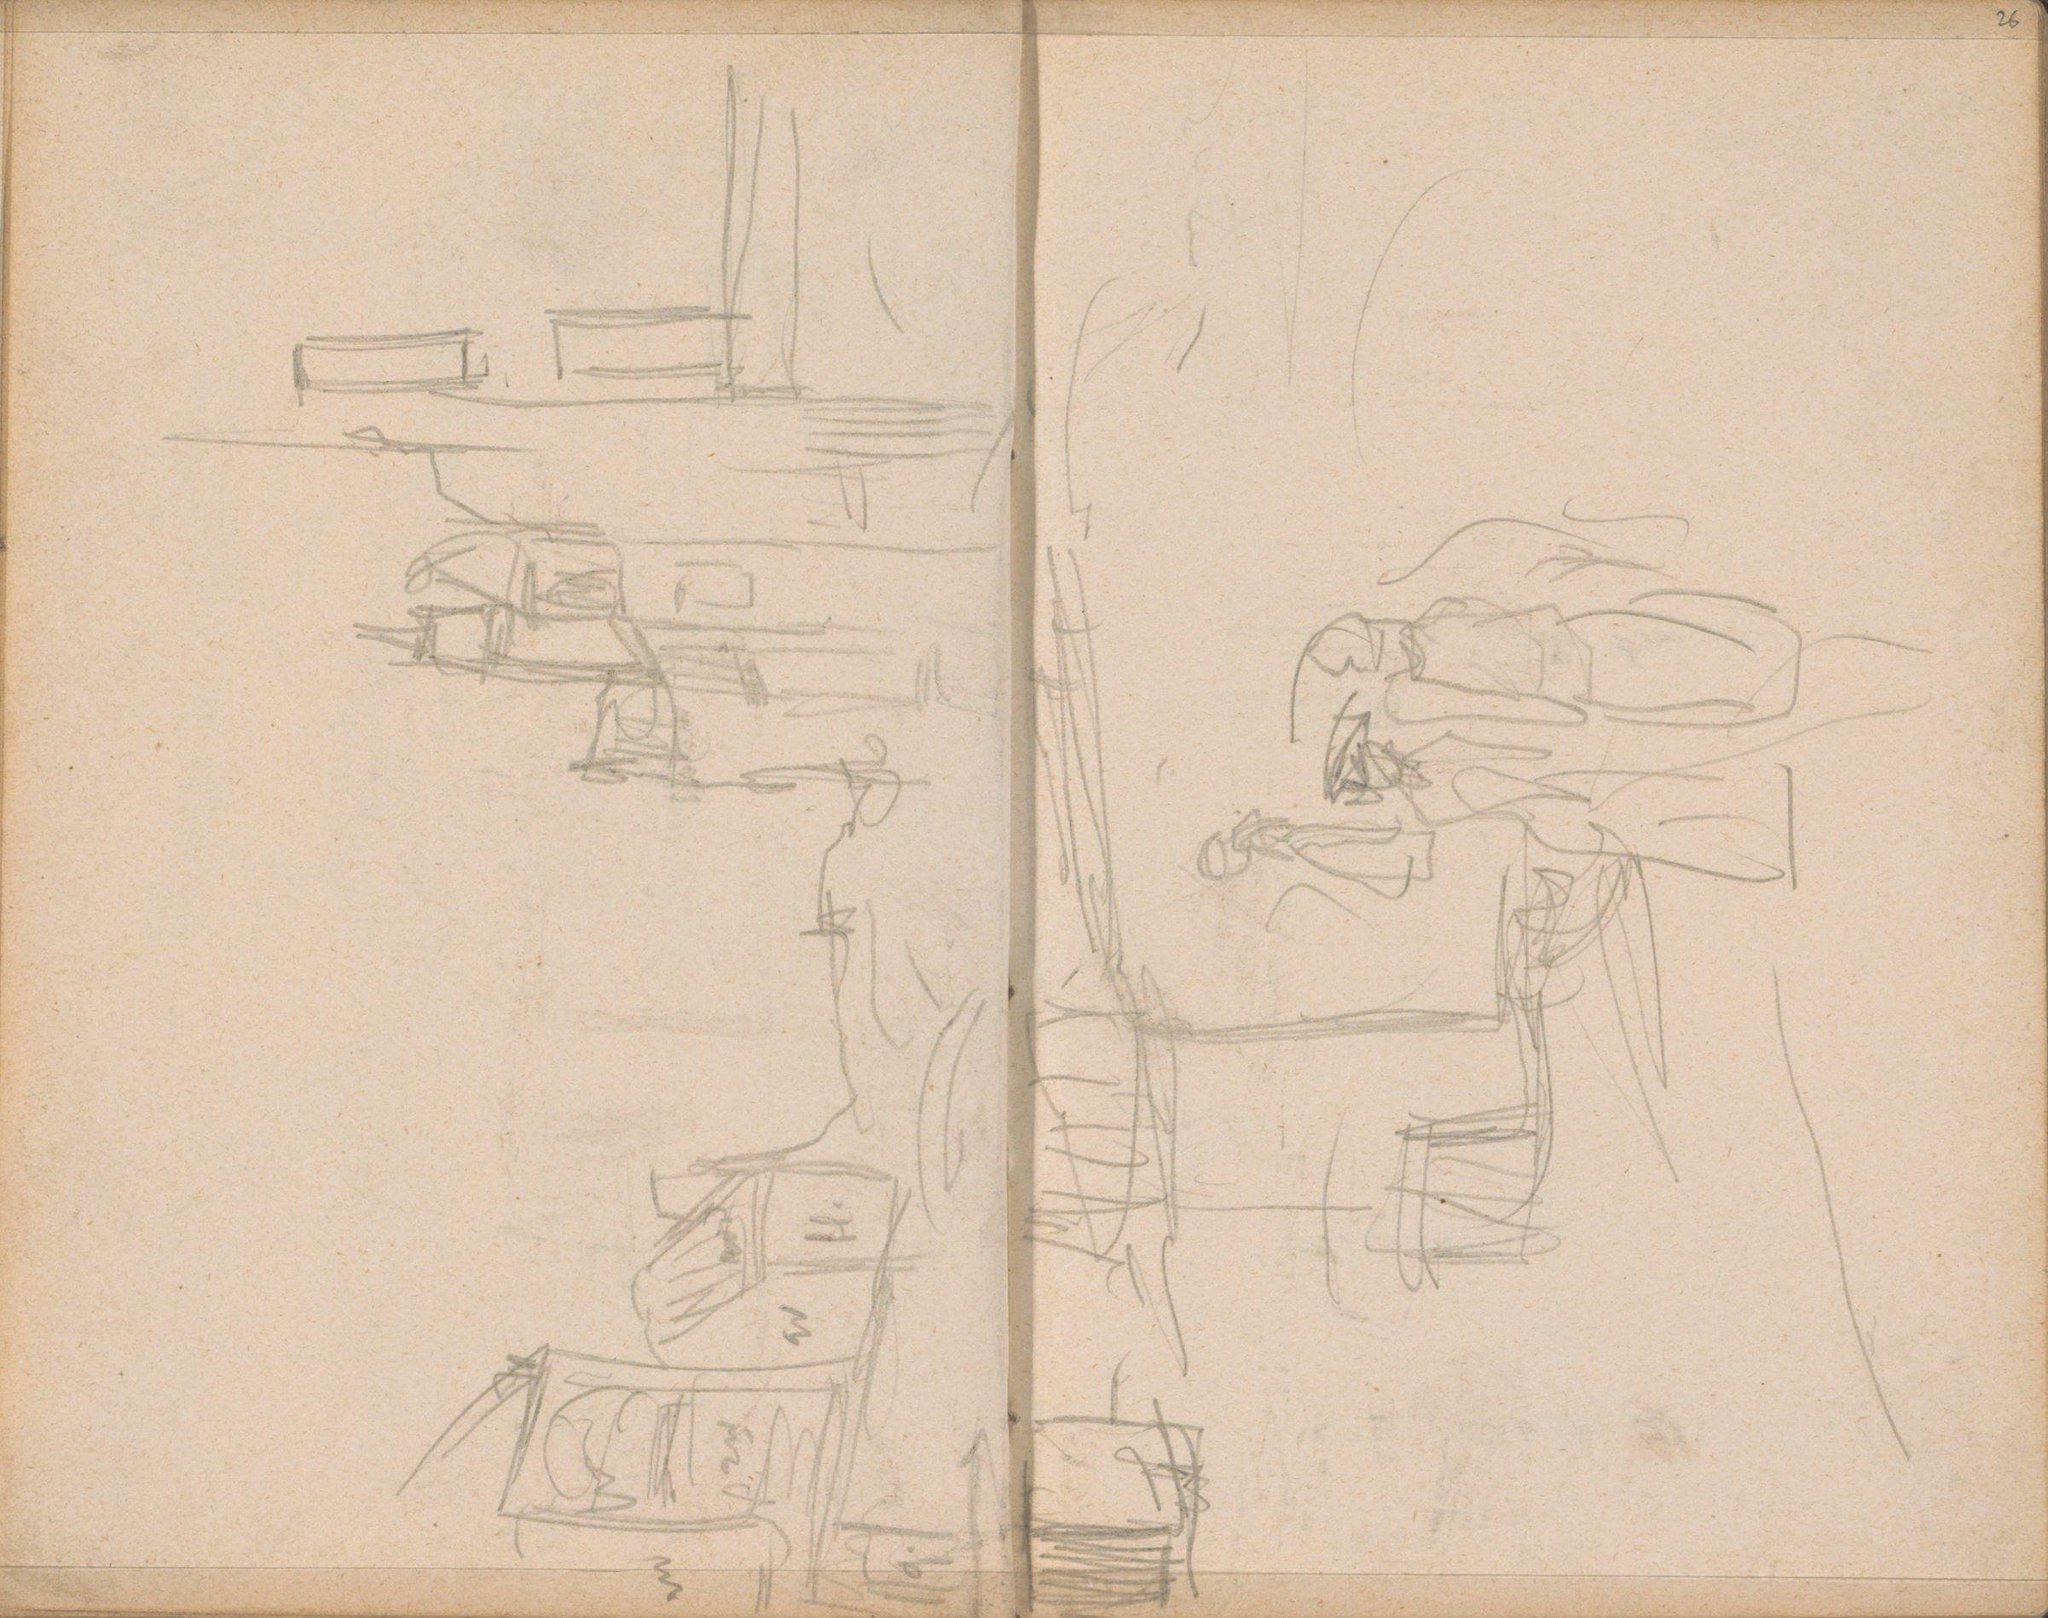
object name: sketchbook leaf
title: Gezicht op een straat met figuren, mogelijk in Amsterdam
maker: george hendrik breitner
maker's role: draughtsman, painter, print maker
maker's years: 1857-1923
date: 1903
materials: paper, pencil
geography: amsterdam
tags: urban housing, street (+ city(-scape) with figures, staffage)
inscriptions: kleurnotitie, handgeschreven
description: Gezicht op een straat met figuren, mogelijk in Amsterdam. Pagina 25 en pagina 26 uit een schetsboek met 46 bladen.